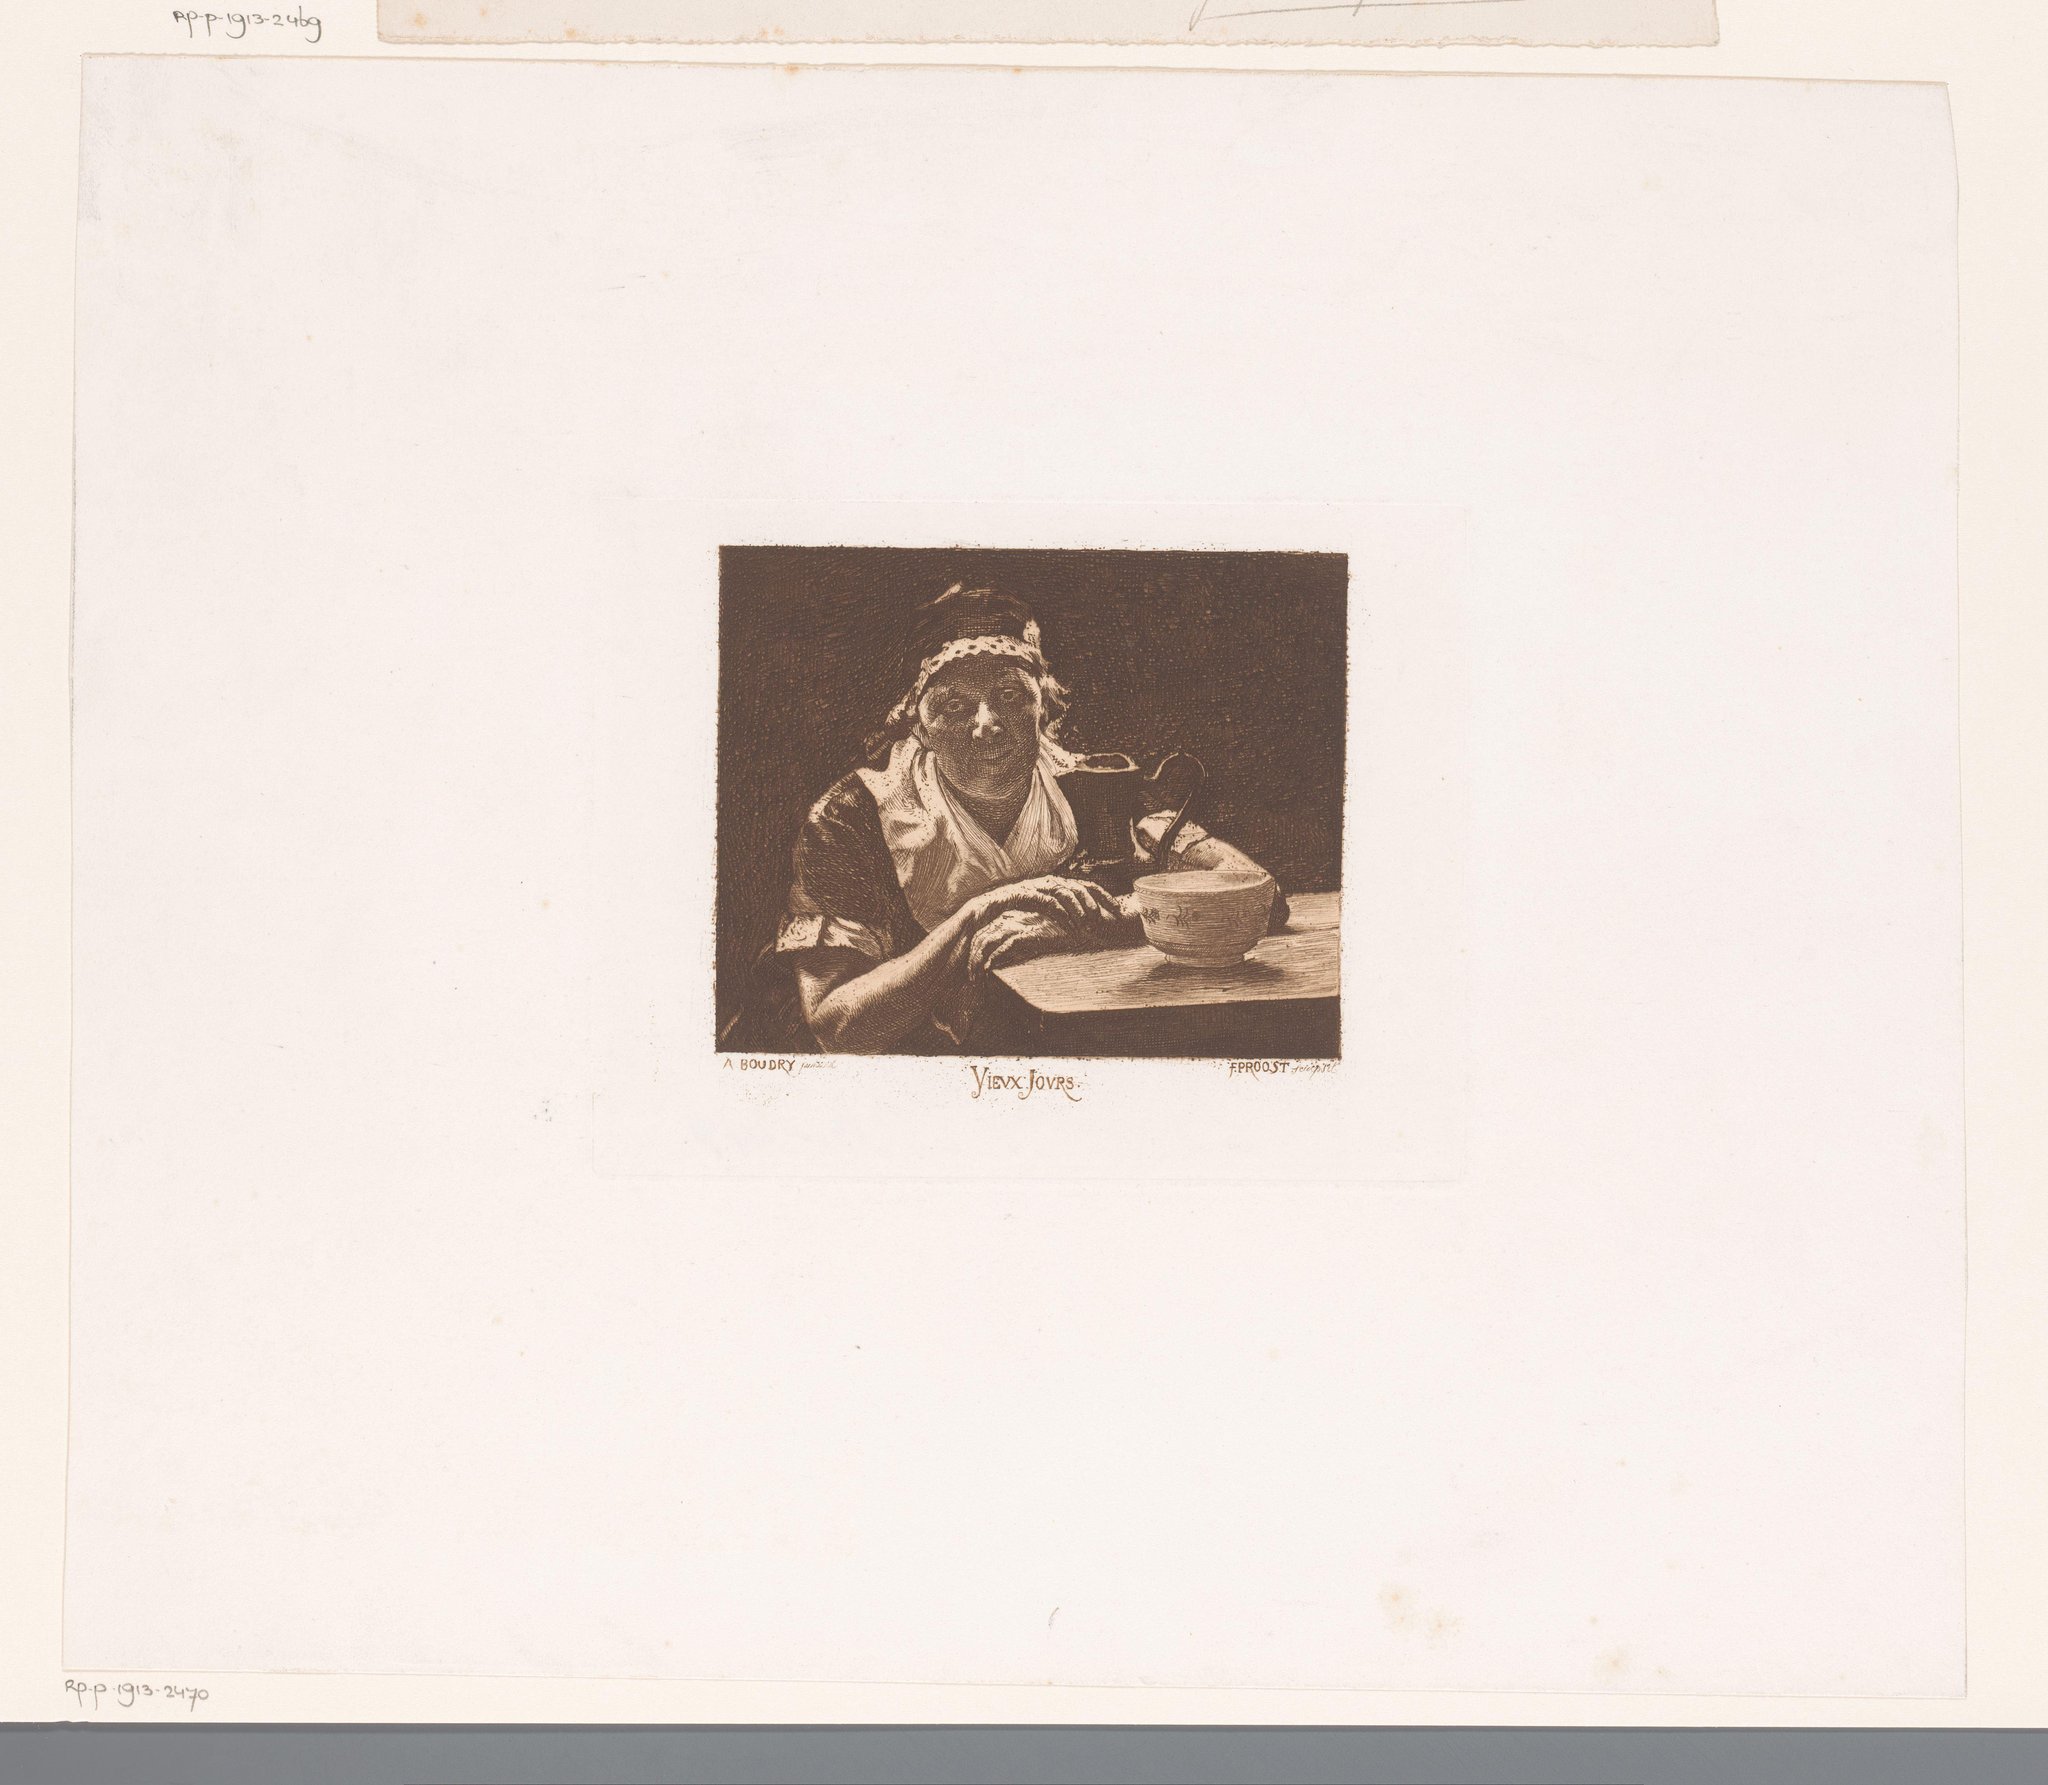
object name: print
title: Vieux jours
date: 1885-1913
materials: paper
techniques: drypoint, etching, intaglio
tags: old woman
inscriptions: collector's mark: Lugt 2228